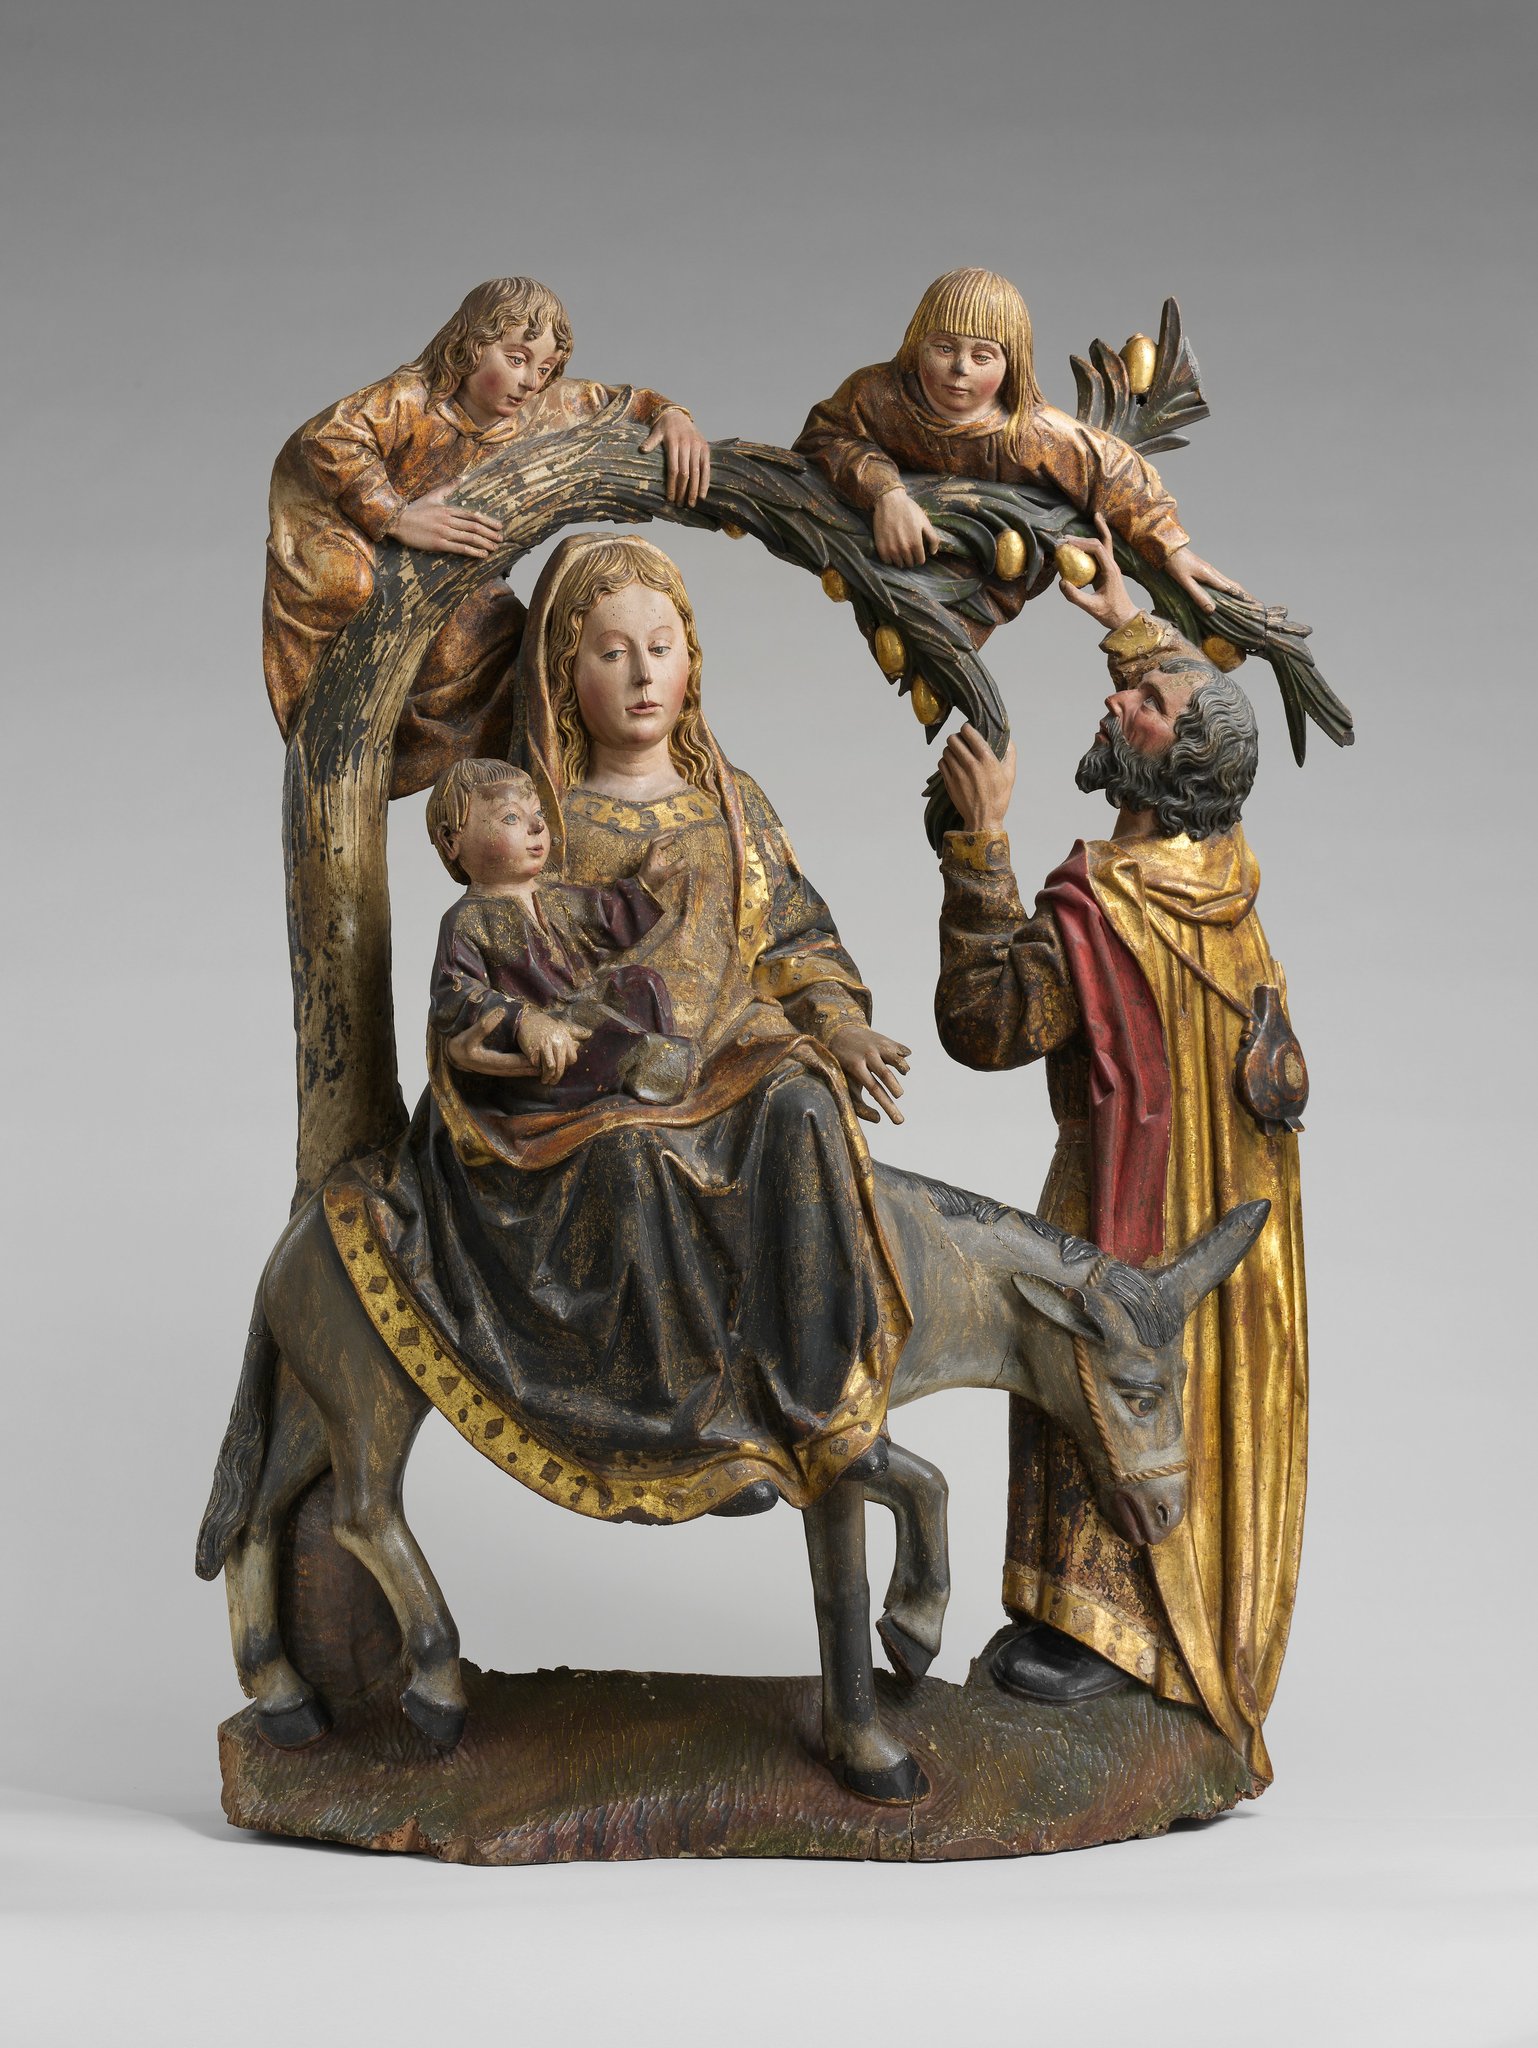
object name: relief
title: The Miracle of the Palm Tree on the Flight to Egypt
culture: spanish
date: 1490-1510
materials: gesso, paint, wood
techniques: gilding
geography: spain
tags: donkeys,angels,christ,saint joseph,virgin mary